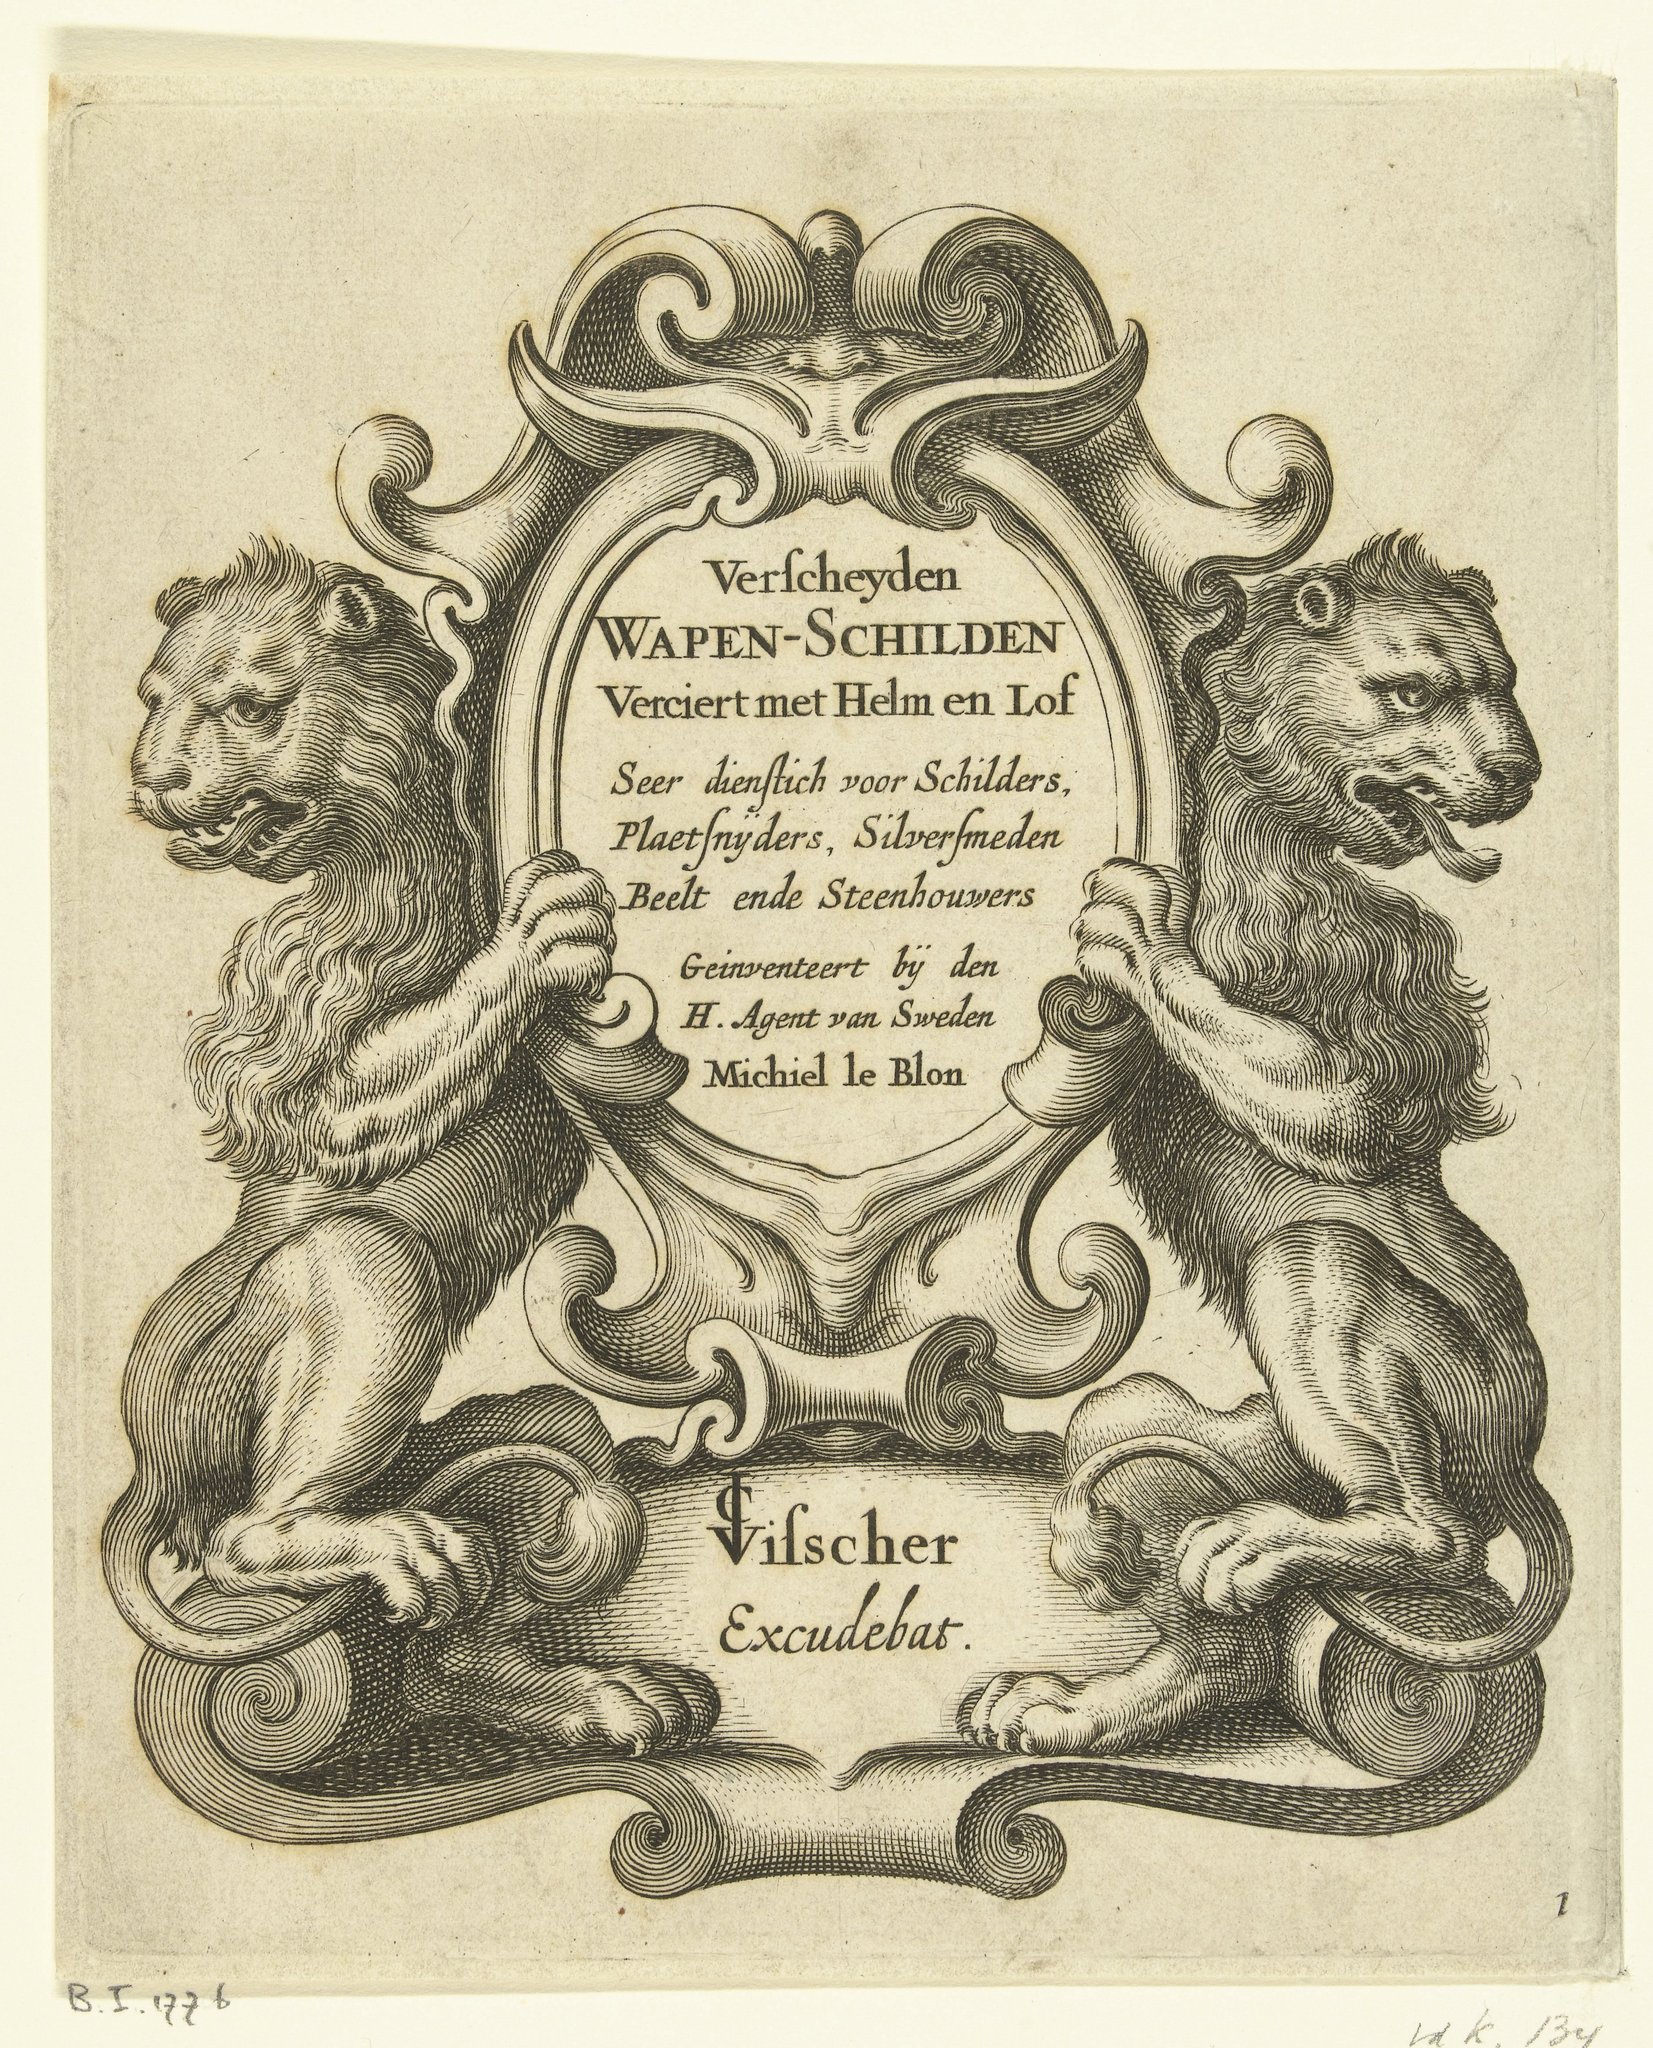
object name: print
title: Verscheyden Wapen-Schilden Verciert met Helm en Lof (...)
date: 1612-1625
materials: paper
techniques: engraving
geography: amsterdam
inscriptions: collector's mark: Lugt 240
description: De cartouche bestaat uit twee compartimenten.